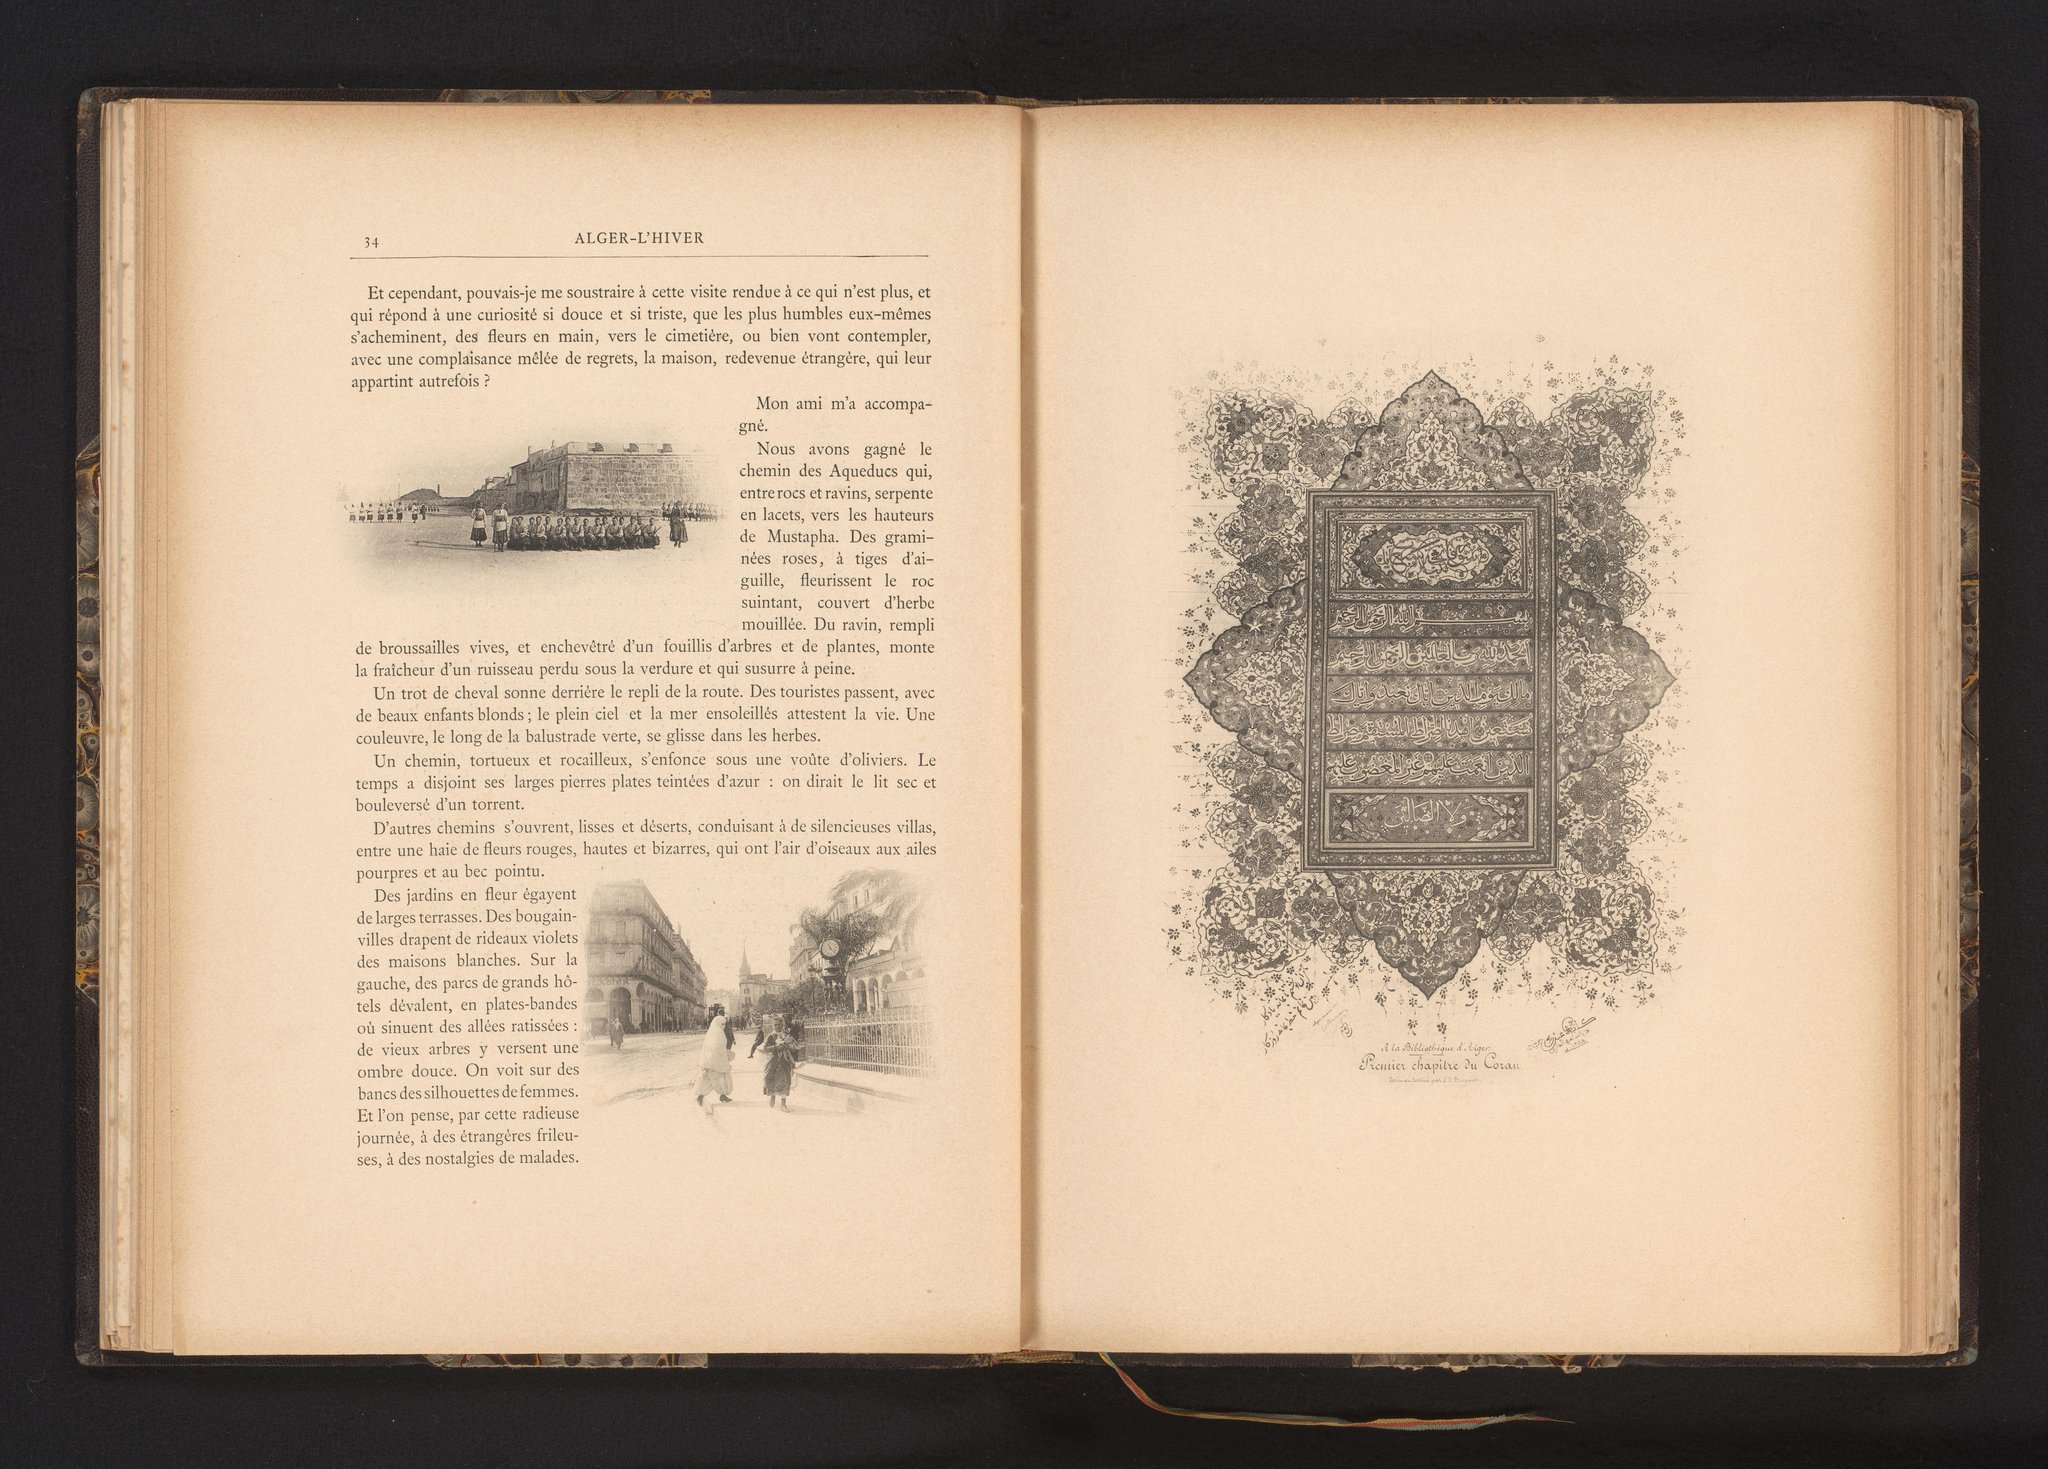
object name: reproduction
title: Reproductie van de eerste pagina van een koran door Louis Jacques Bresnier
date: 1888-1893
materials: paper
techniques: photograph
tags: places and objects of worship ~ islam, mohammedanism, title-page